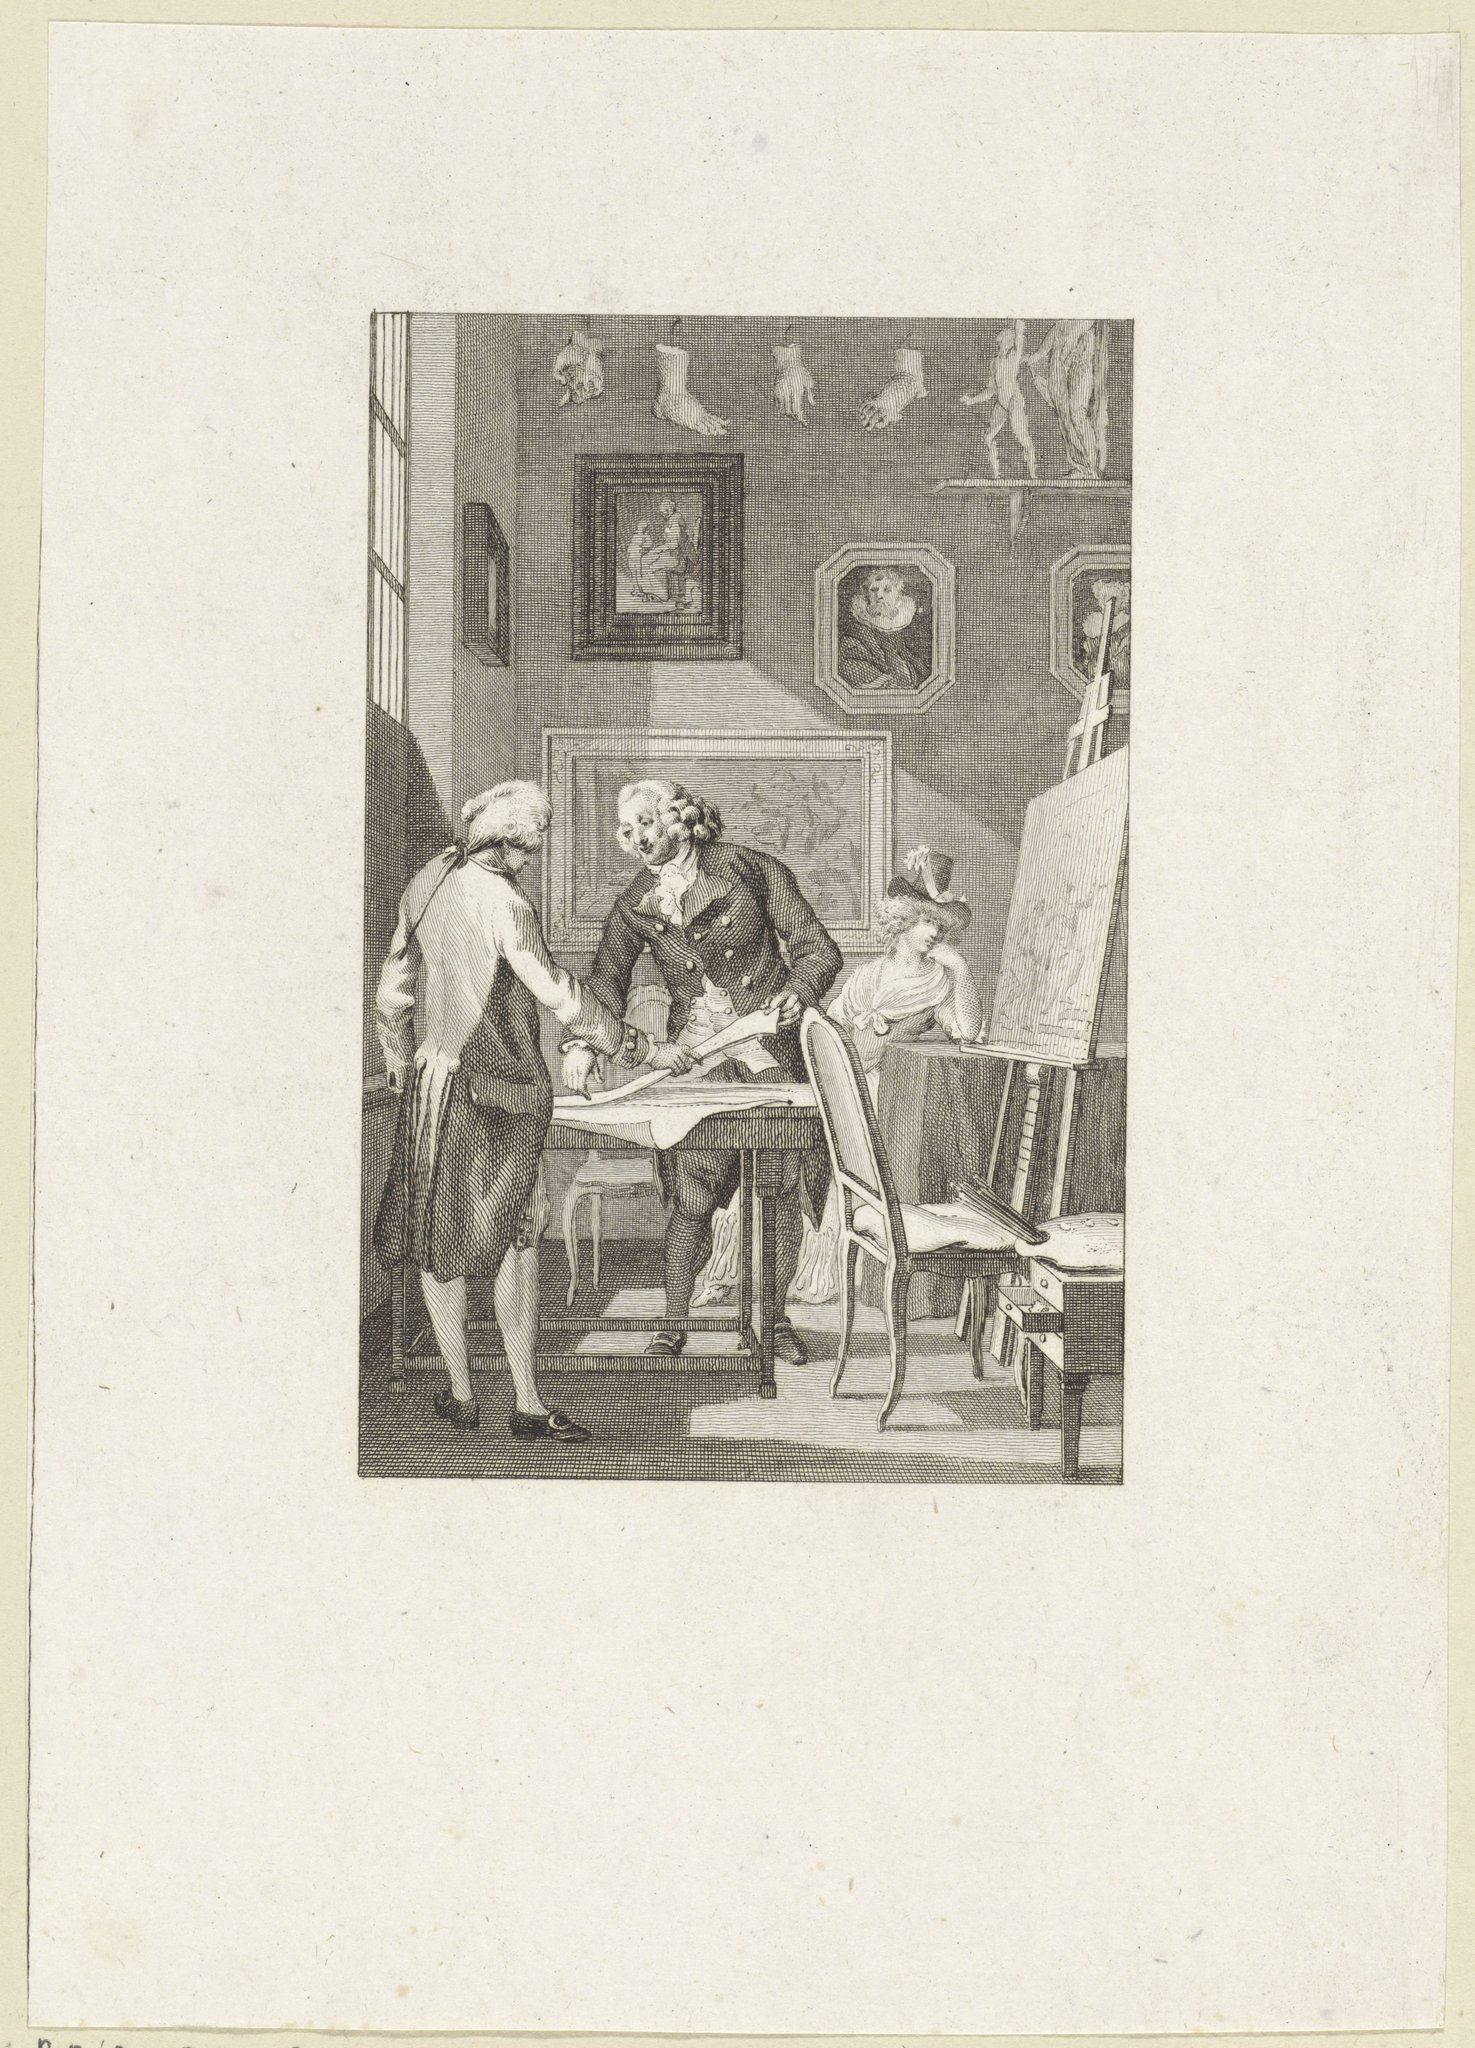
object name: print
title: Man toont schetsen aan een andere man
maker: reinier vinkeles (i)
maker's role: draughtsman, print maker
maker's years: 1741-1816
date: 1791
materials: paper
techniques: engraving, etching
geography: amsterdam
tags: workshop, studio ~ painter, picture, painting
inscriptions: collector's mark: Lugt 240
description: Proefdruk van een prent die mogelijk ook gebruikt is als illustratie in: Louiza en Volsan: tooneelspel in drie bedryven. Amsterdam: erven van Pieter Meĳer en Gerrit Warnars, 1791.